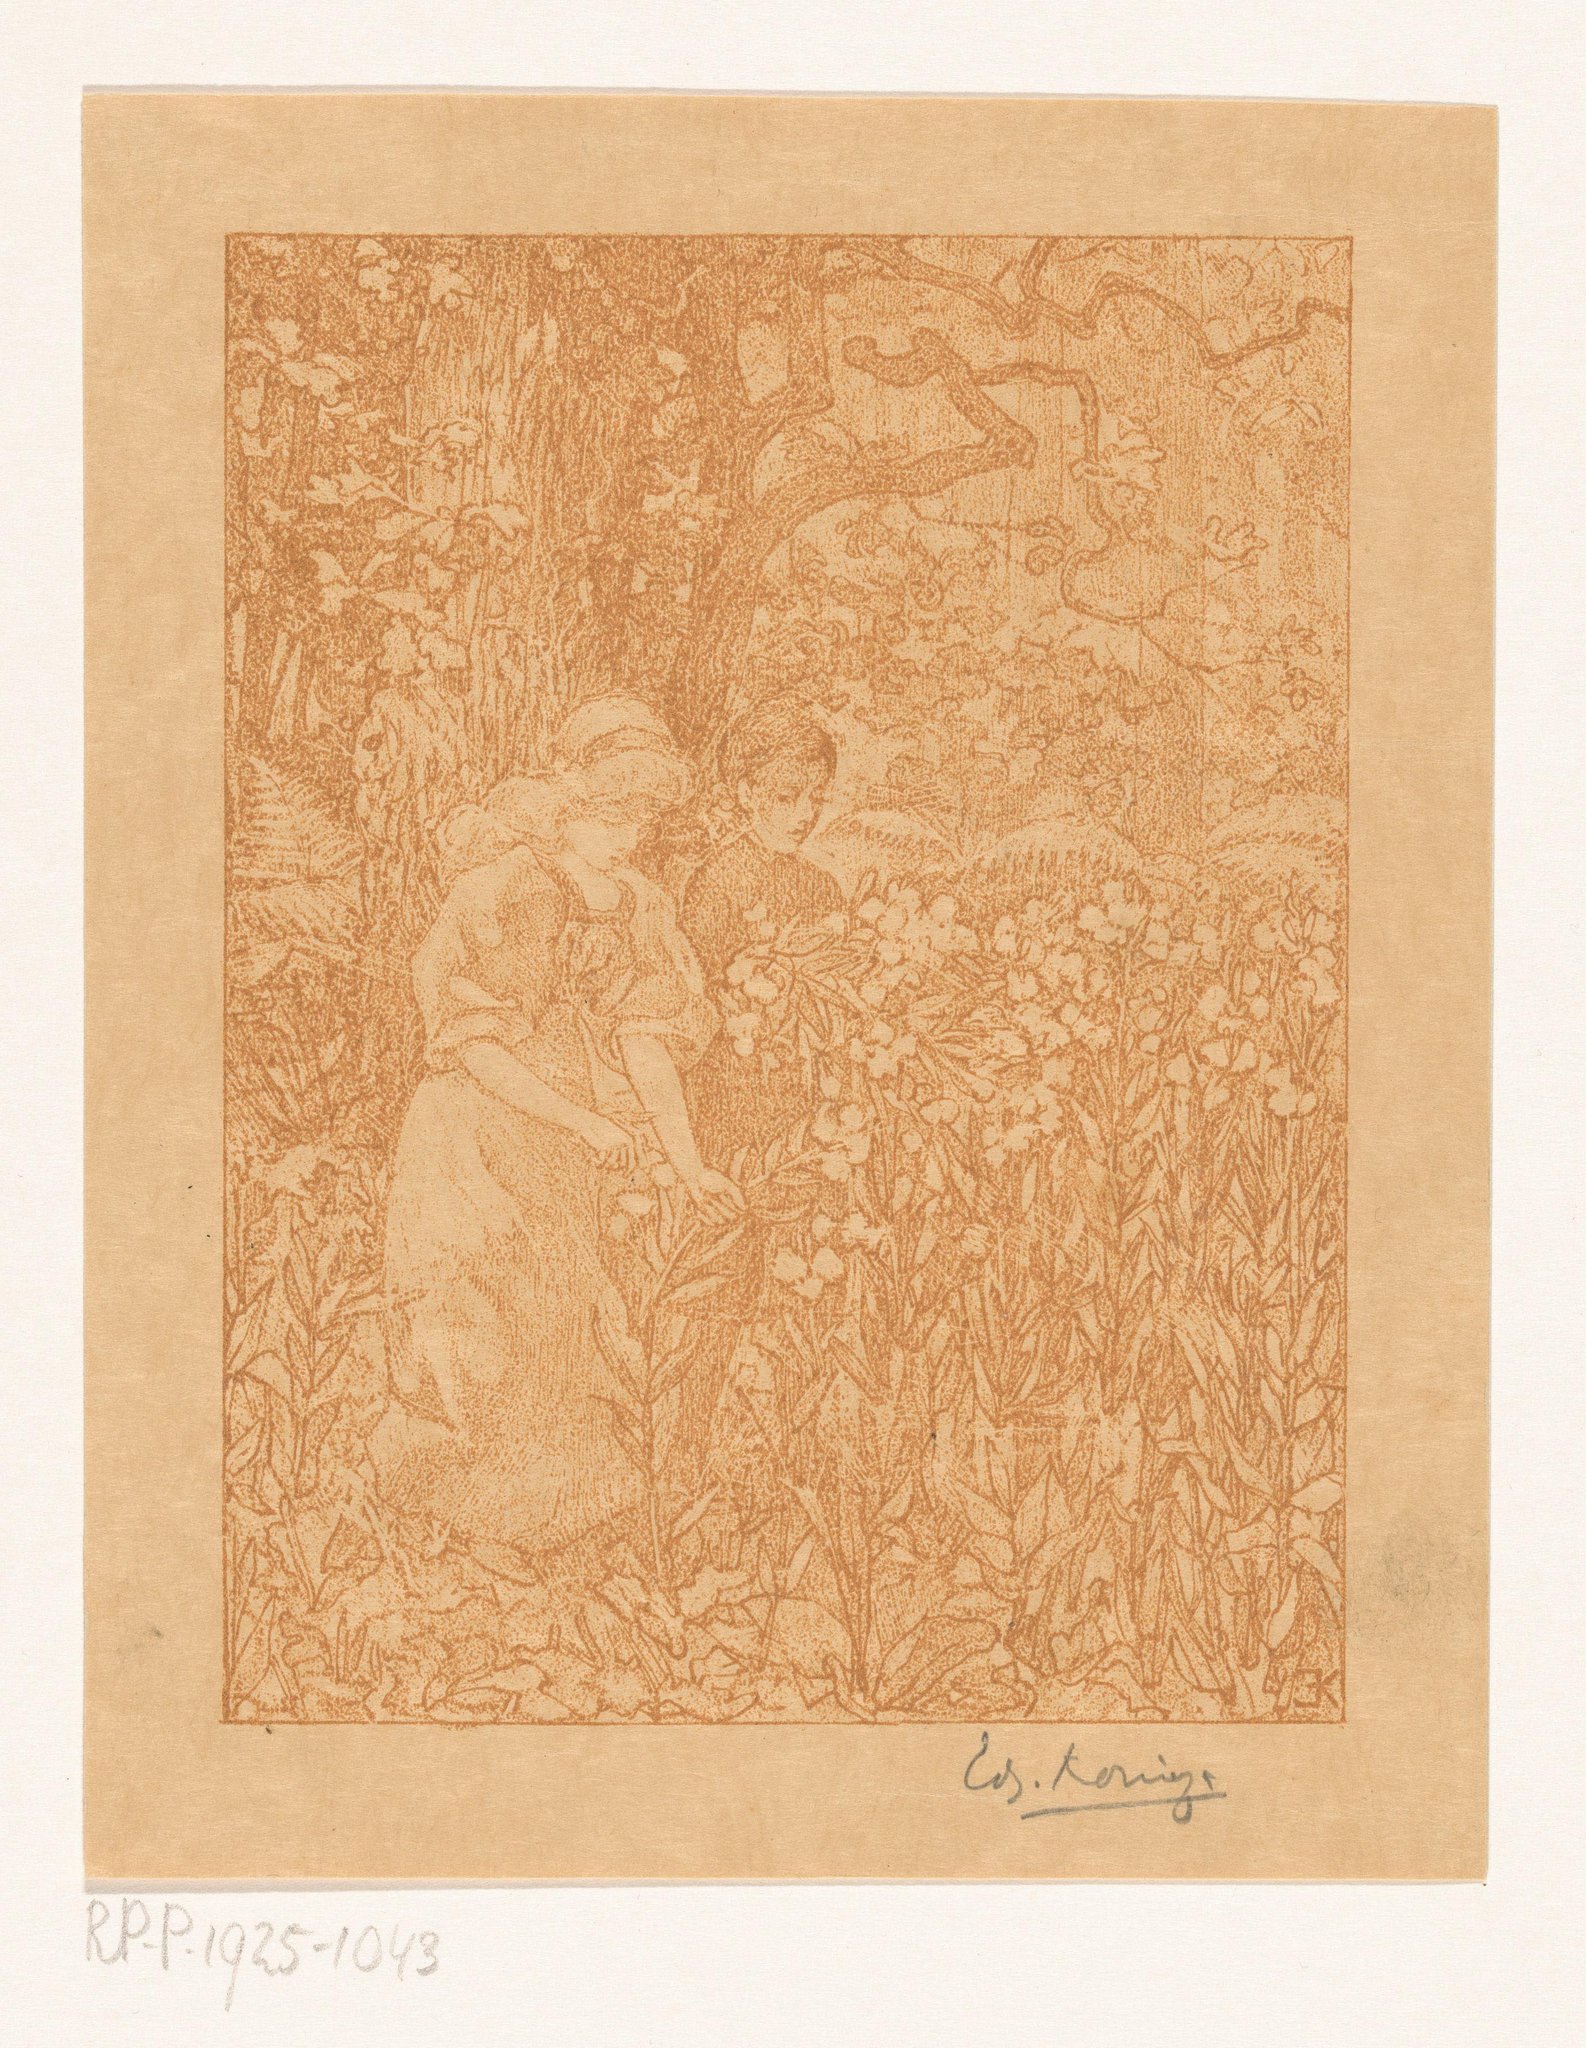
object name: boekillustratie ontwerp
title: Johannes en Robinetta in een veld met bloemen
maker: edzard koning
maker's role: draughtsman, print maker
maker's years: 1869-1954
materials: paper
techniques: lithograph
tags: picking flowers, flowers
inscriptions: collector's mark: Lugt 2228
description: Ontwerp voor: Eeden, Frederik van, De kleine Johannes. Den Haag: Mouton & Co., 1898.